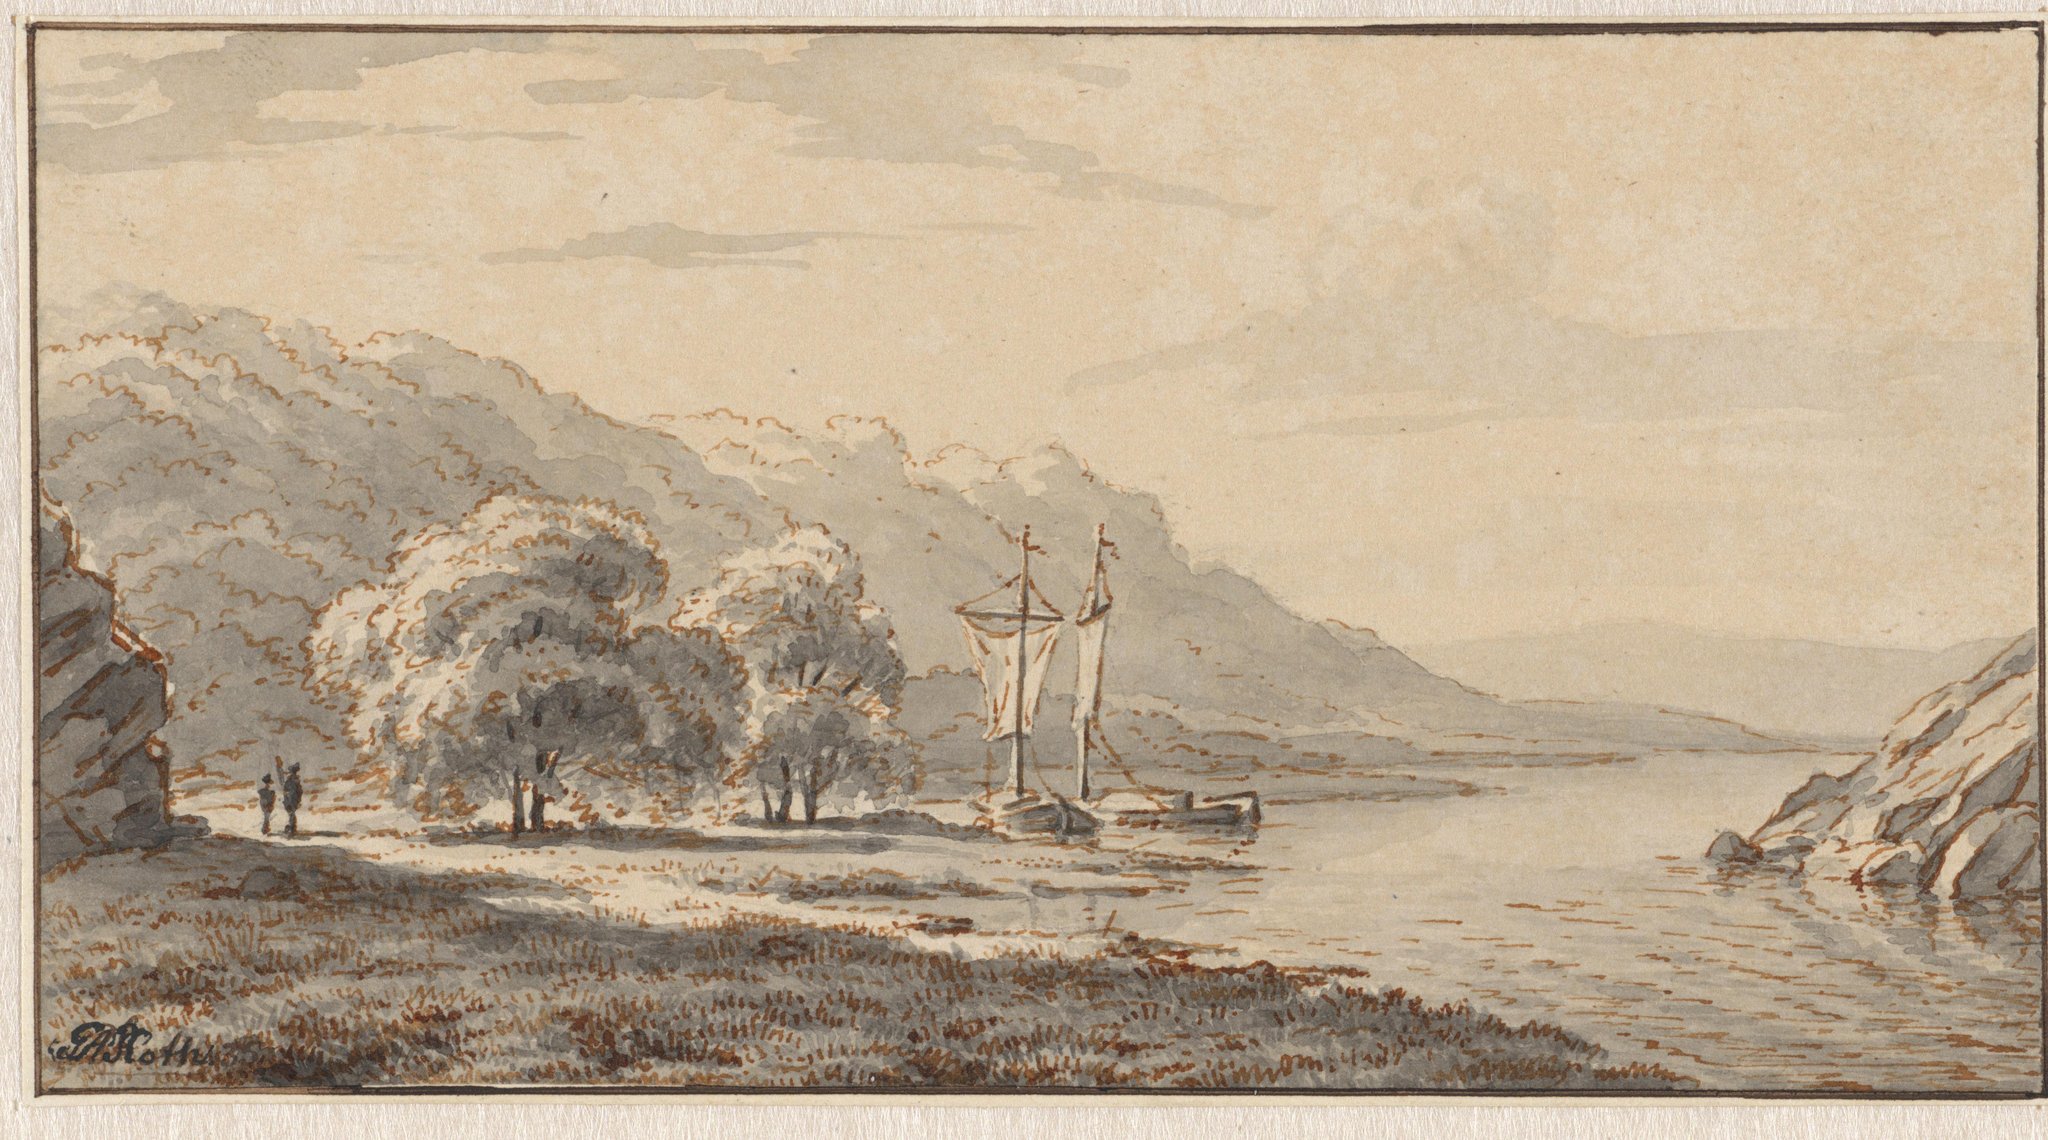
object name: drawing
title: Rivierlandschap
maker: george andries roth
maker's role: draughtsman, painter, print maker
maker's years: 1809-1887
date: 1819-1887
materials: ink, paper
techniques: brush, pen